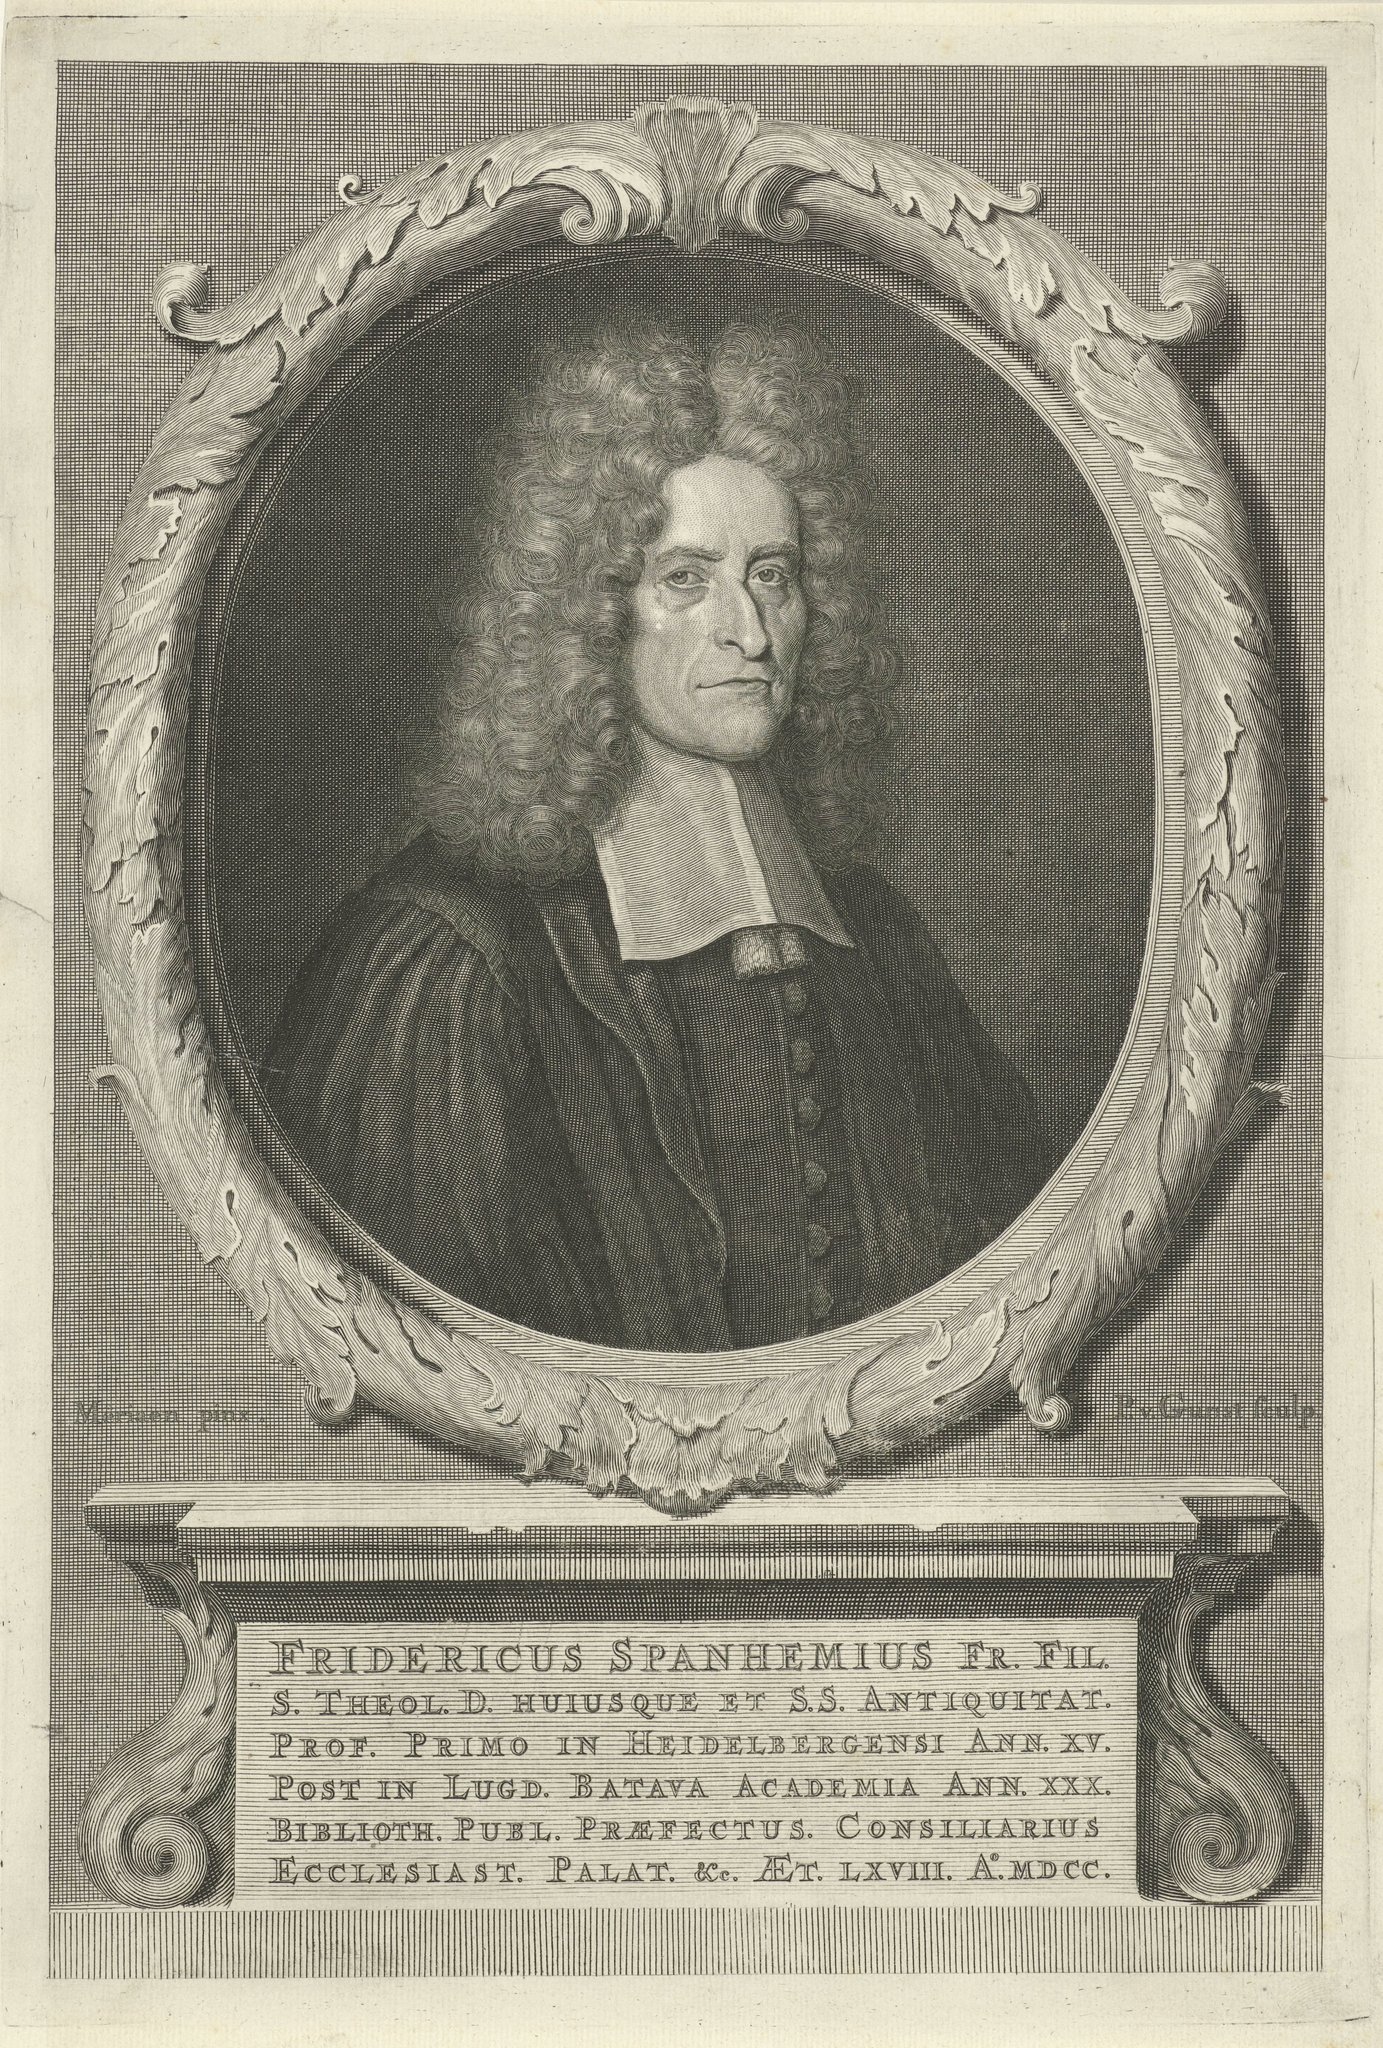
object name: print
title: Portret van Frederick Spanheim de jongere op 68-jarige leeftijd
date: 1700-1731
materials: paper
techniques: engraving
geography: amsterdam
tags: theoloog, professor, hervormer, frederick spanheim (ii)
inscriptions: collector's mark: Lugt 2228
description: Frederick Spanheim de jongere, Zwitsers theoloog en professor bij de universiteit van Utrecht, op 62-jarige leeftijd. Met Latijns onderschrift.